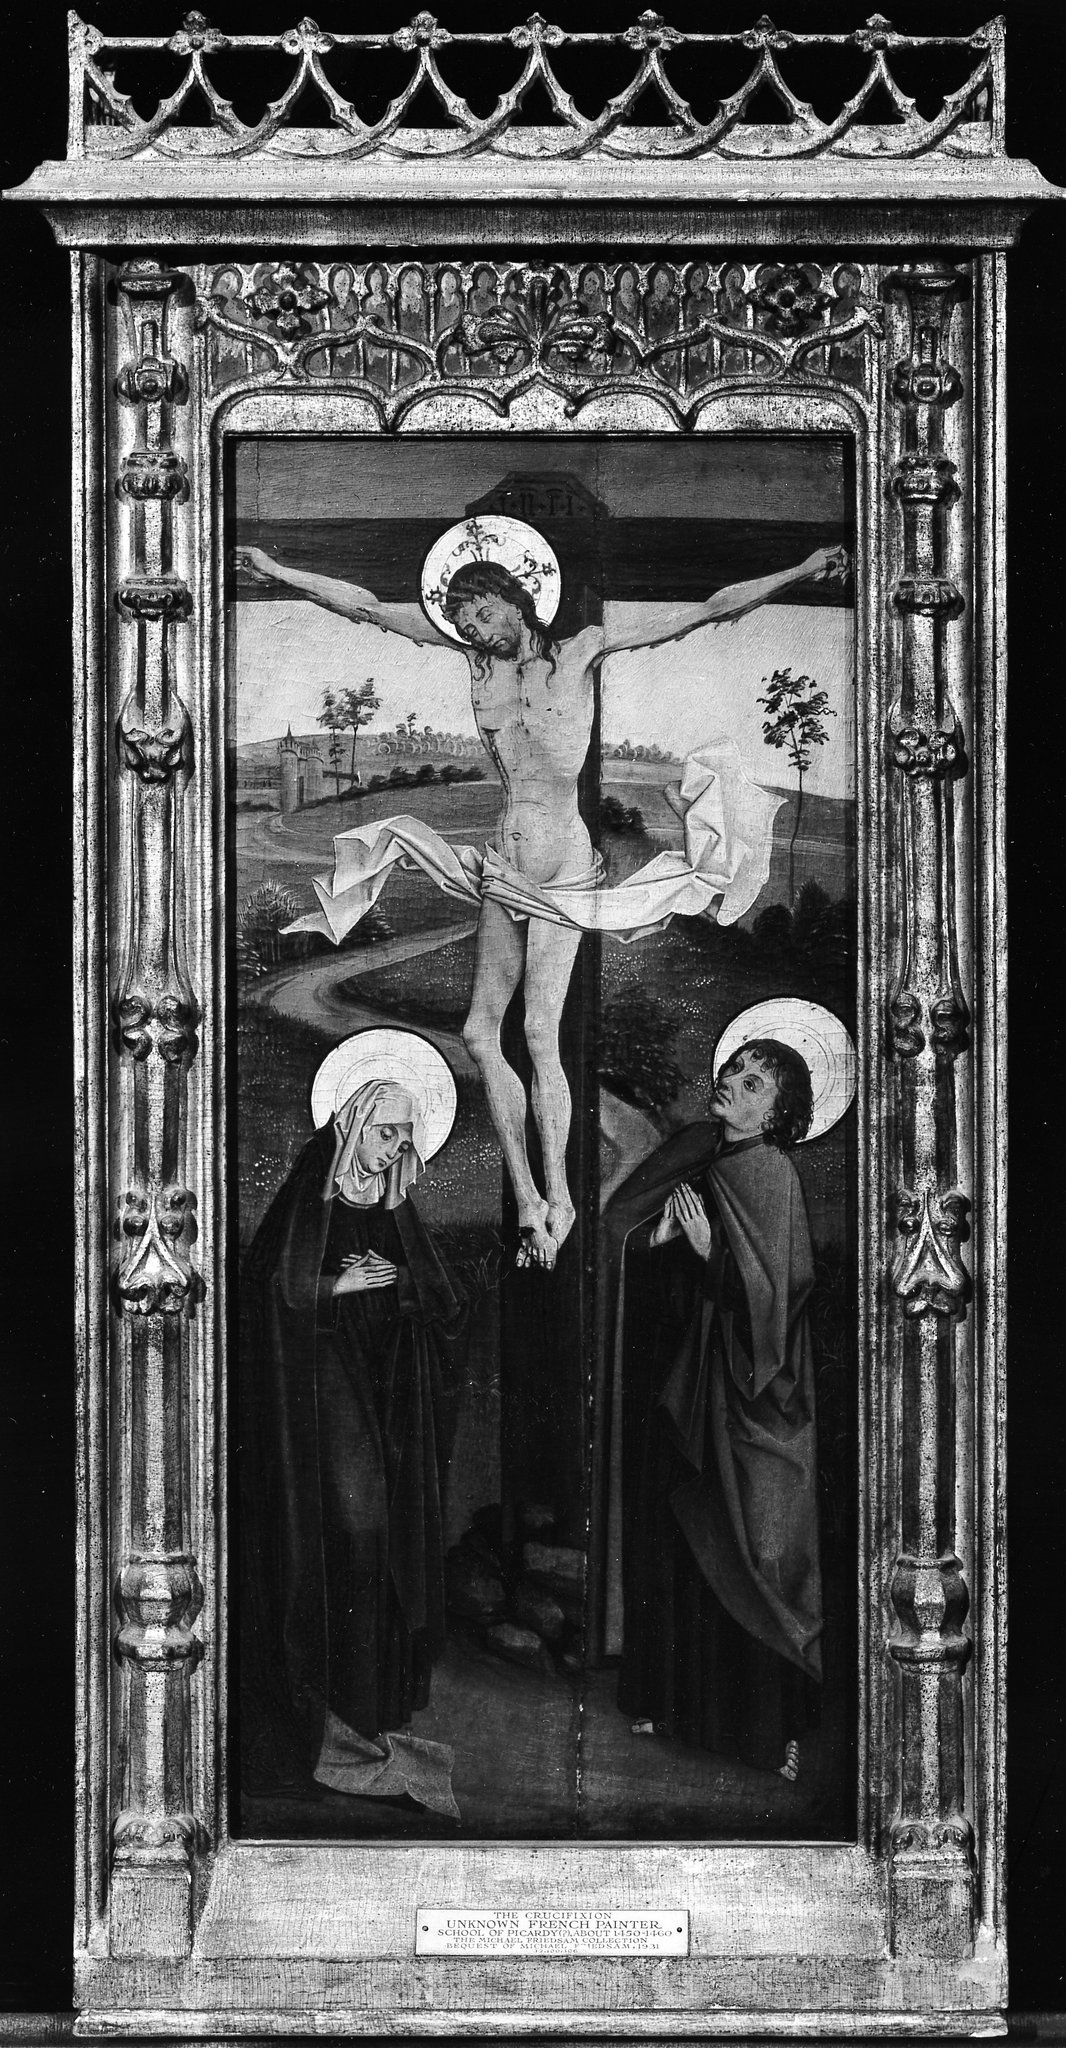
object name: painting, wing of an altarpiece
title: The Crucifixion, (reverse) Saint Francis of Assisi; The Resurrection, (reverse) An Abbot Saint, Possibly Saint Benedict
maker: northern french painter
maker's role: artist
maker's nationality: french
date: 1455-1465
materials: oil, wood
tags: soldiers,men,christ,saint francis,crucifixion,resurrection